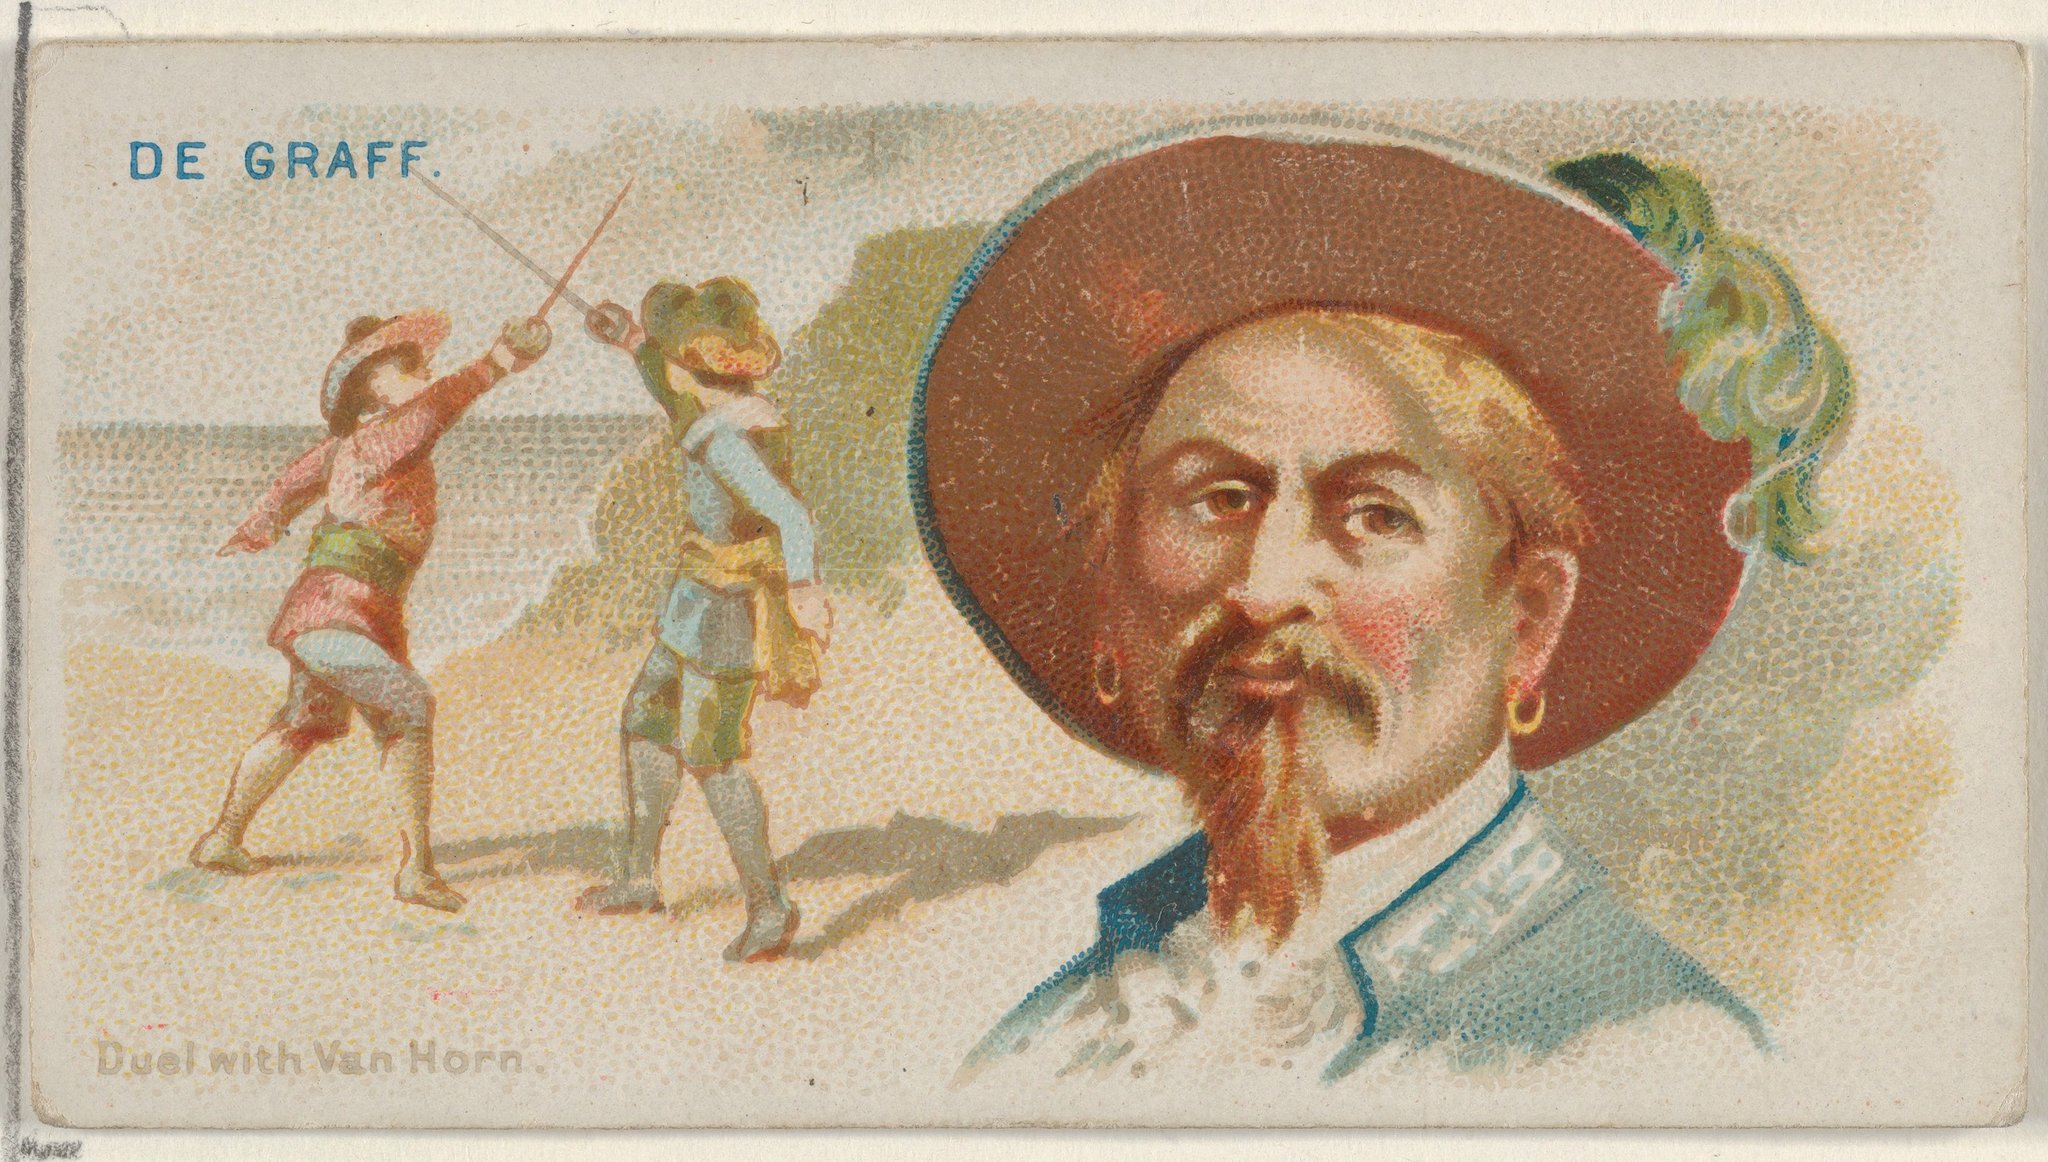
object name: print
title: De Graaf, Duel with Van Horn, from the Pirates of the Spanish Main series (N19) for Allen & Ginter Cigarettes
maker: allen & ginter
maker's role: publisher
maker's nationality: american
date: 1888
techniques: color lithograph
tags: men